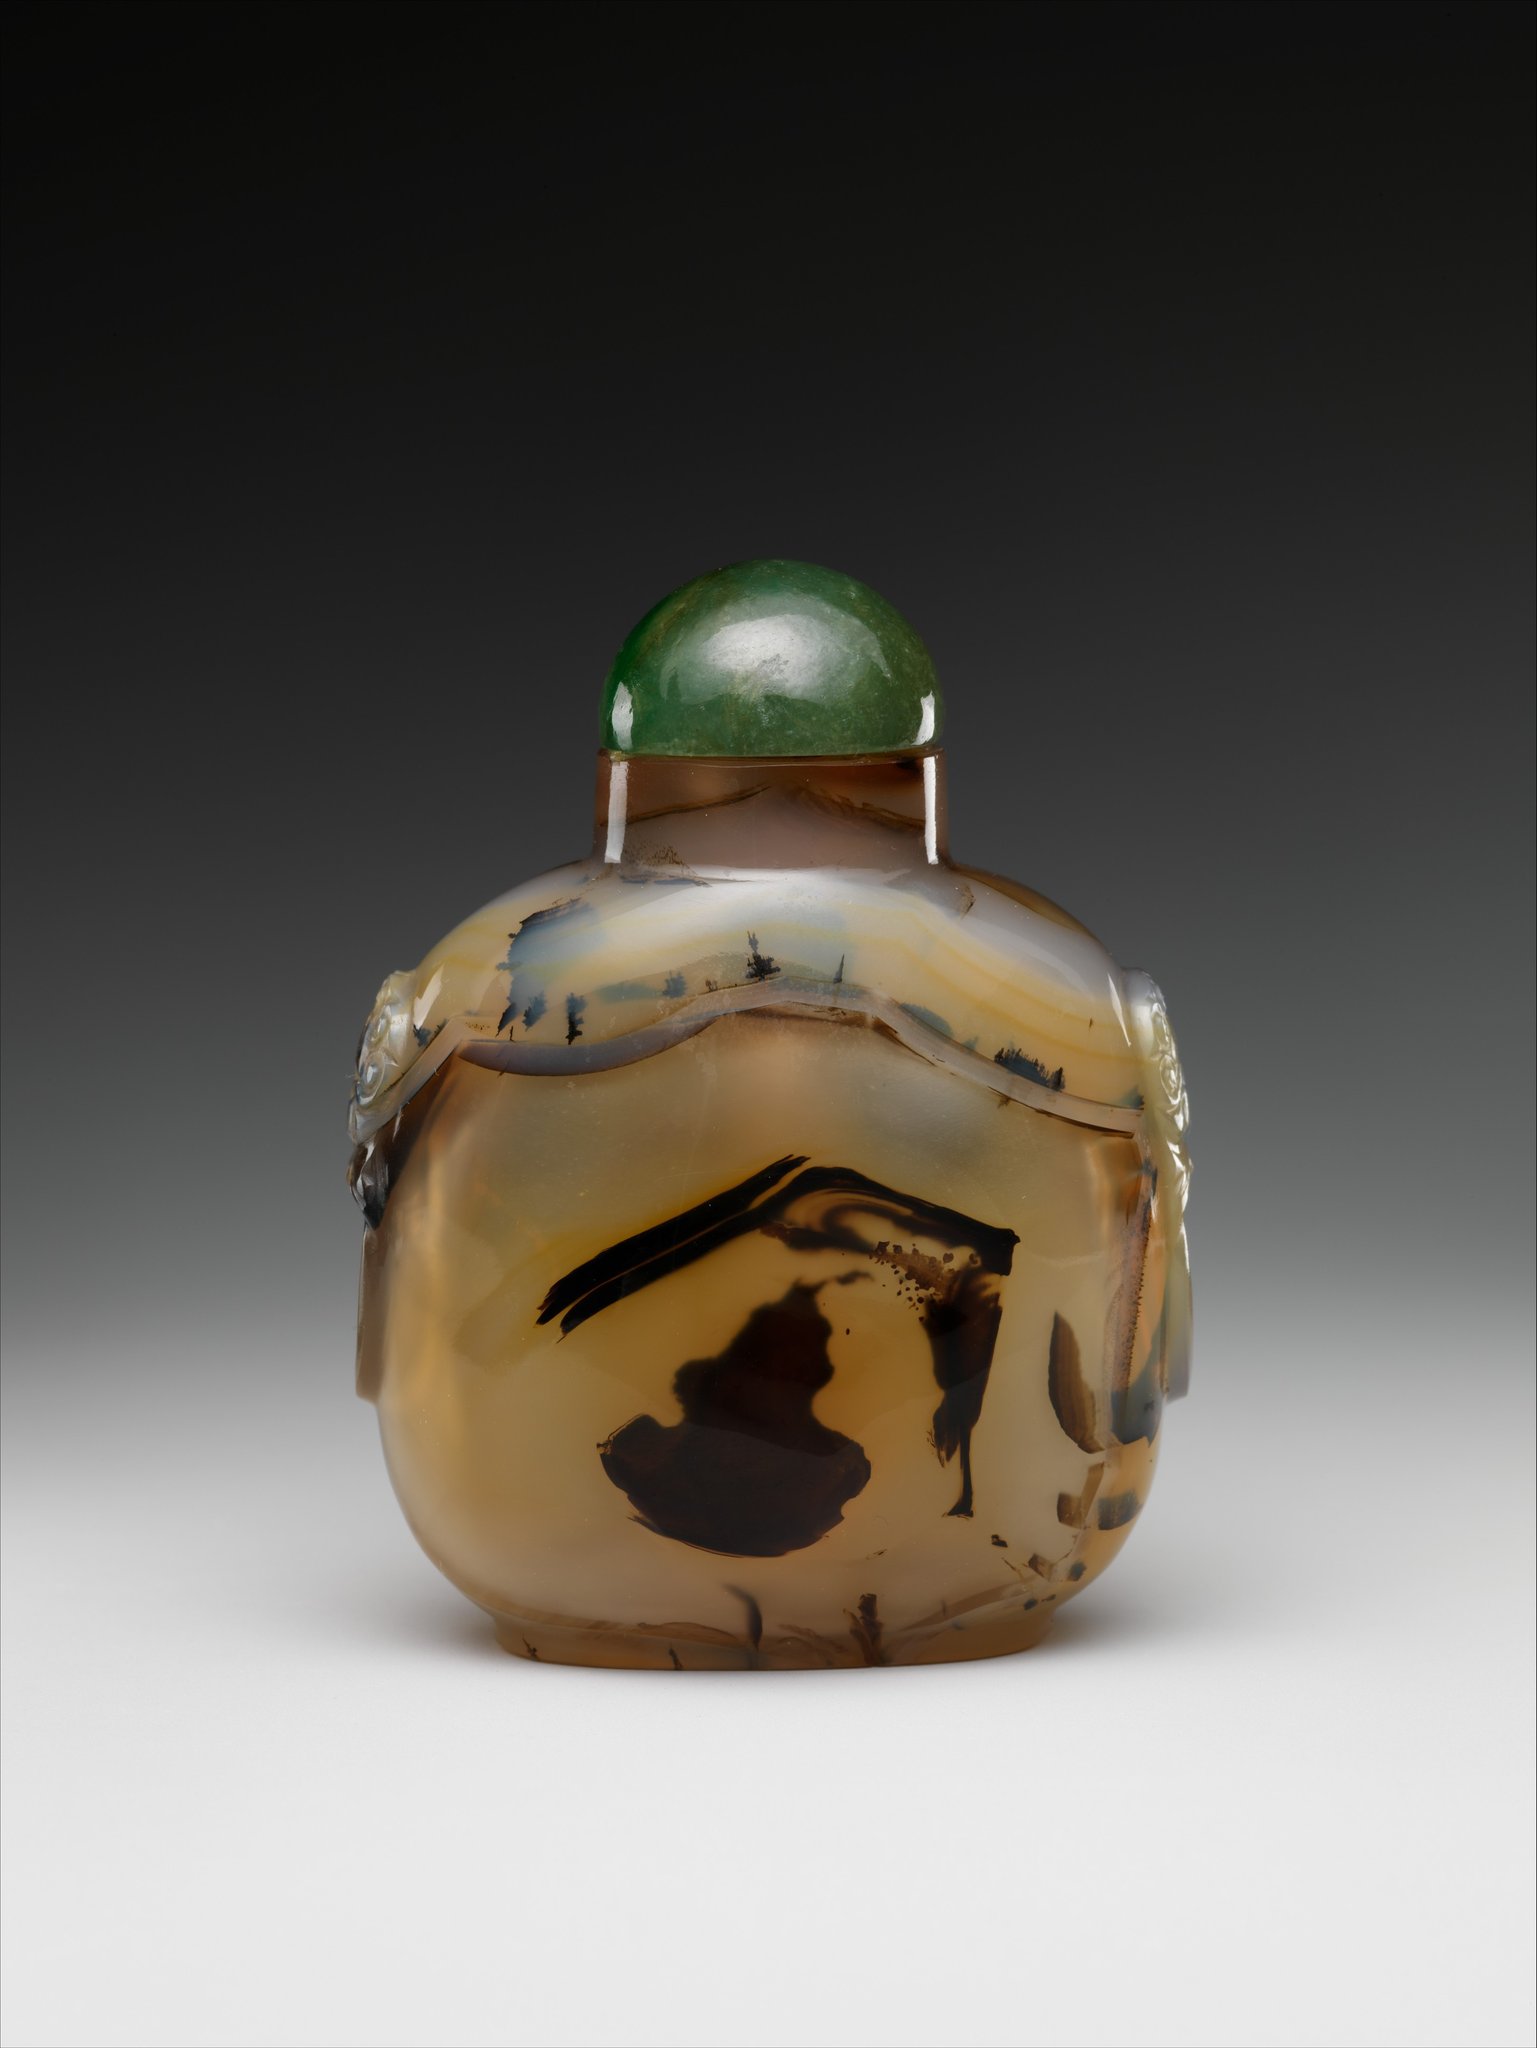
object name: snuff bottle with stopper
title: Snuff bottle with gourd on a trellis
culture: chinese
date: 1767-1900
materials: stone, jade